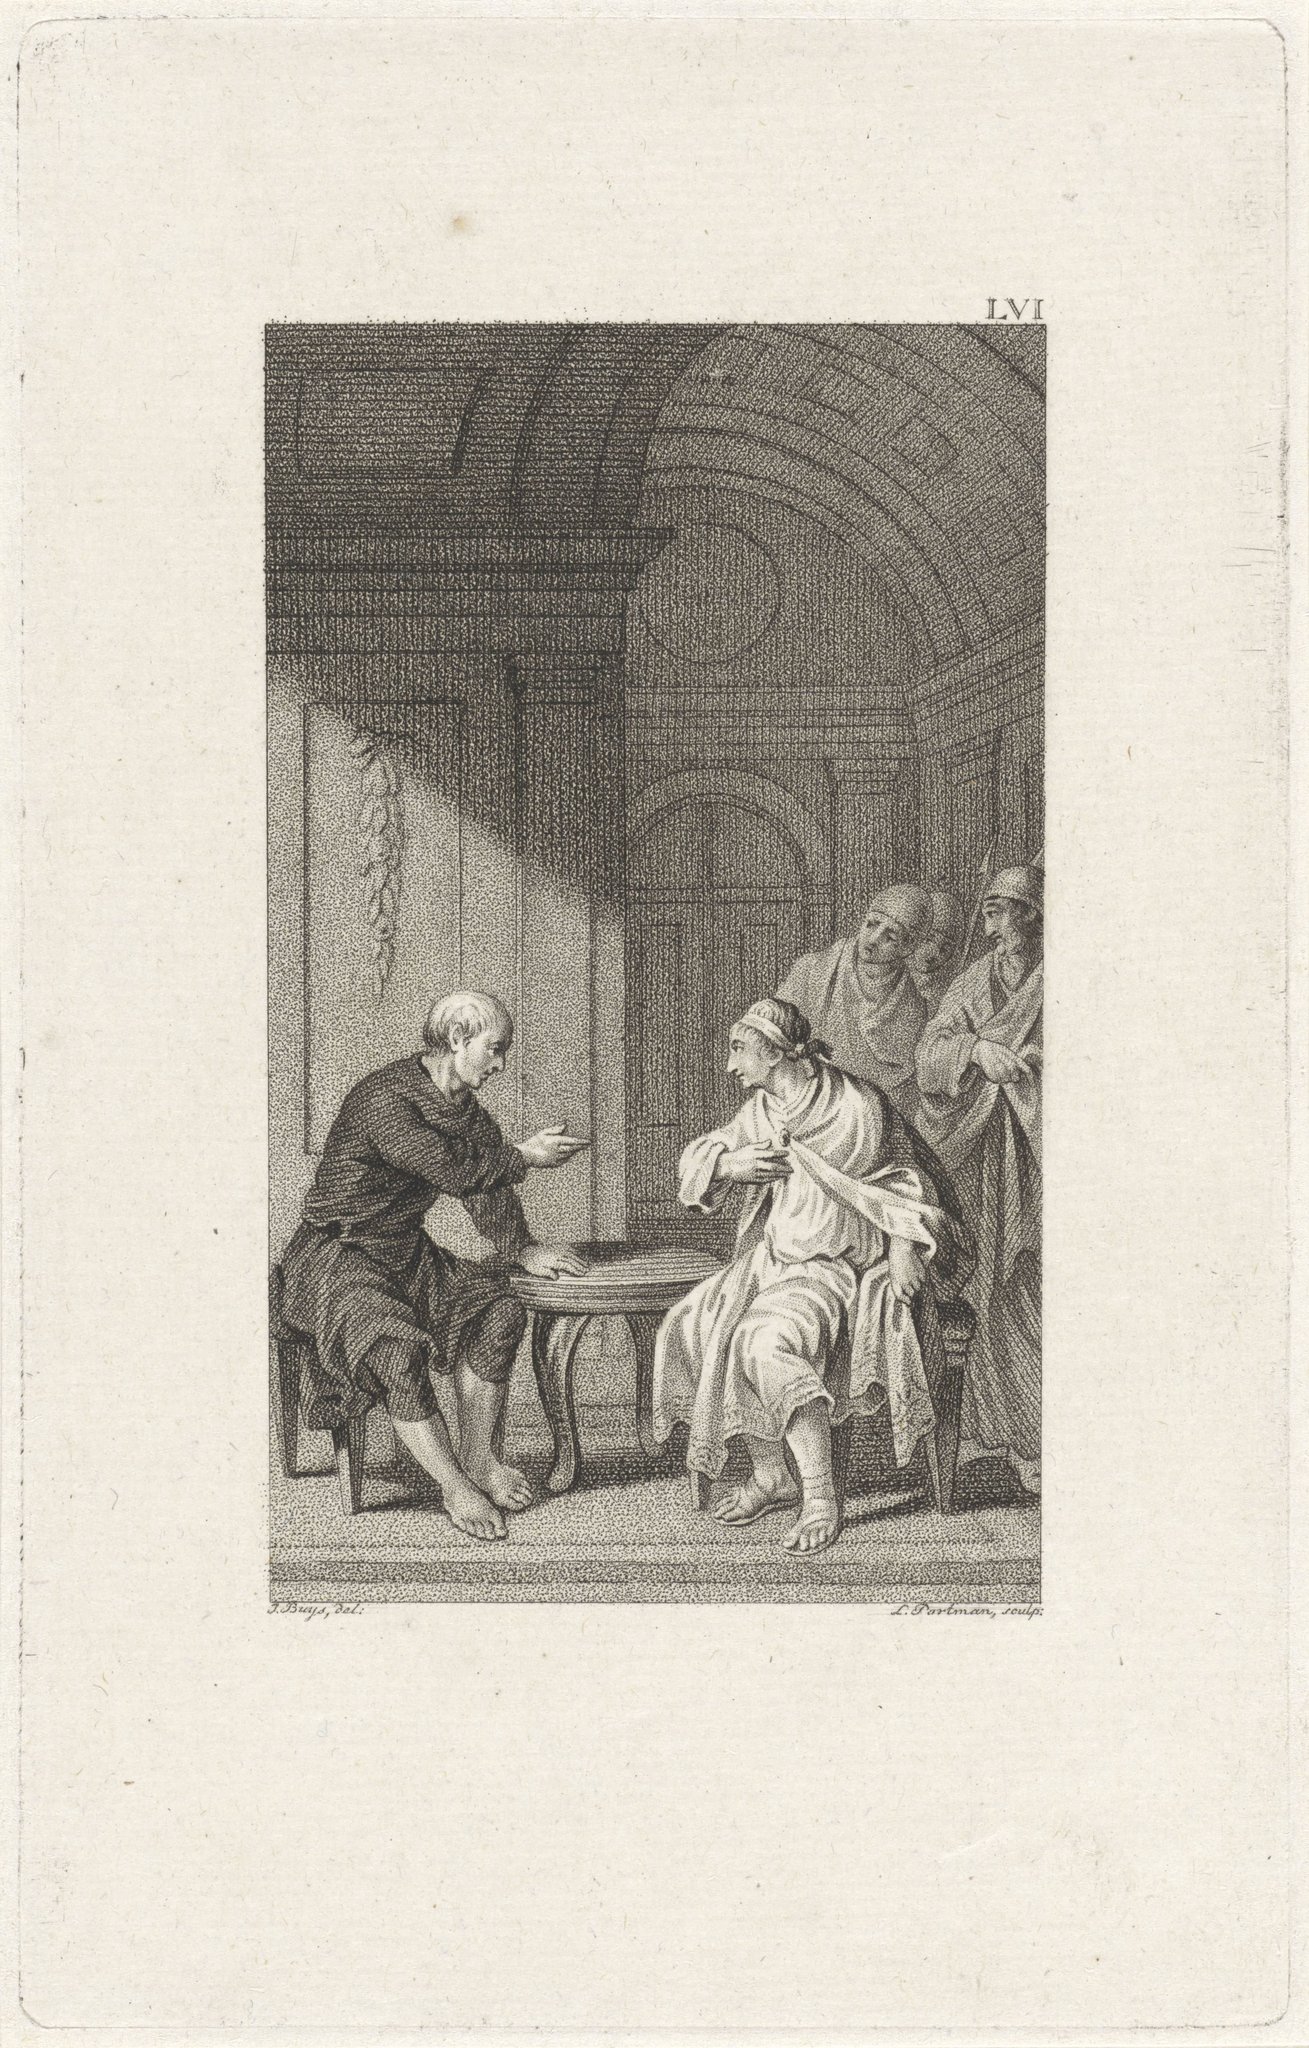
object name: book illustration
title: Cato en Ptolemaeus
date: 1799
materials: paper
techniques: etching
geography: amsterdam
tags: (story of) marcus porcius cato the younger - non-aggressive activities of person from classical history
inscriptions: collector's mark: Lugt 2228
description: Cato de Jongere biedt Ptolemaeus van Cyprus aan om de functie als hogepriester van Aphrodite in Paphos, als compensatie voor het verlies van zijn koningschap, te aanvaarden.